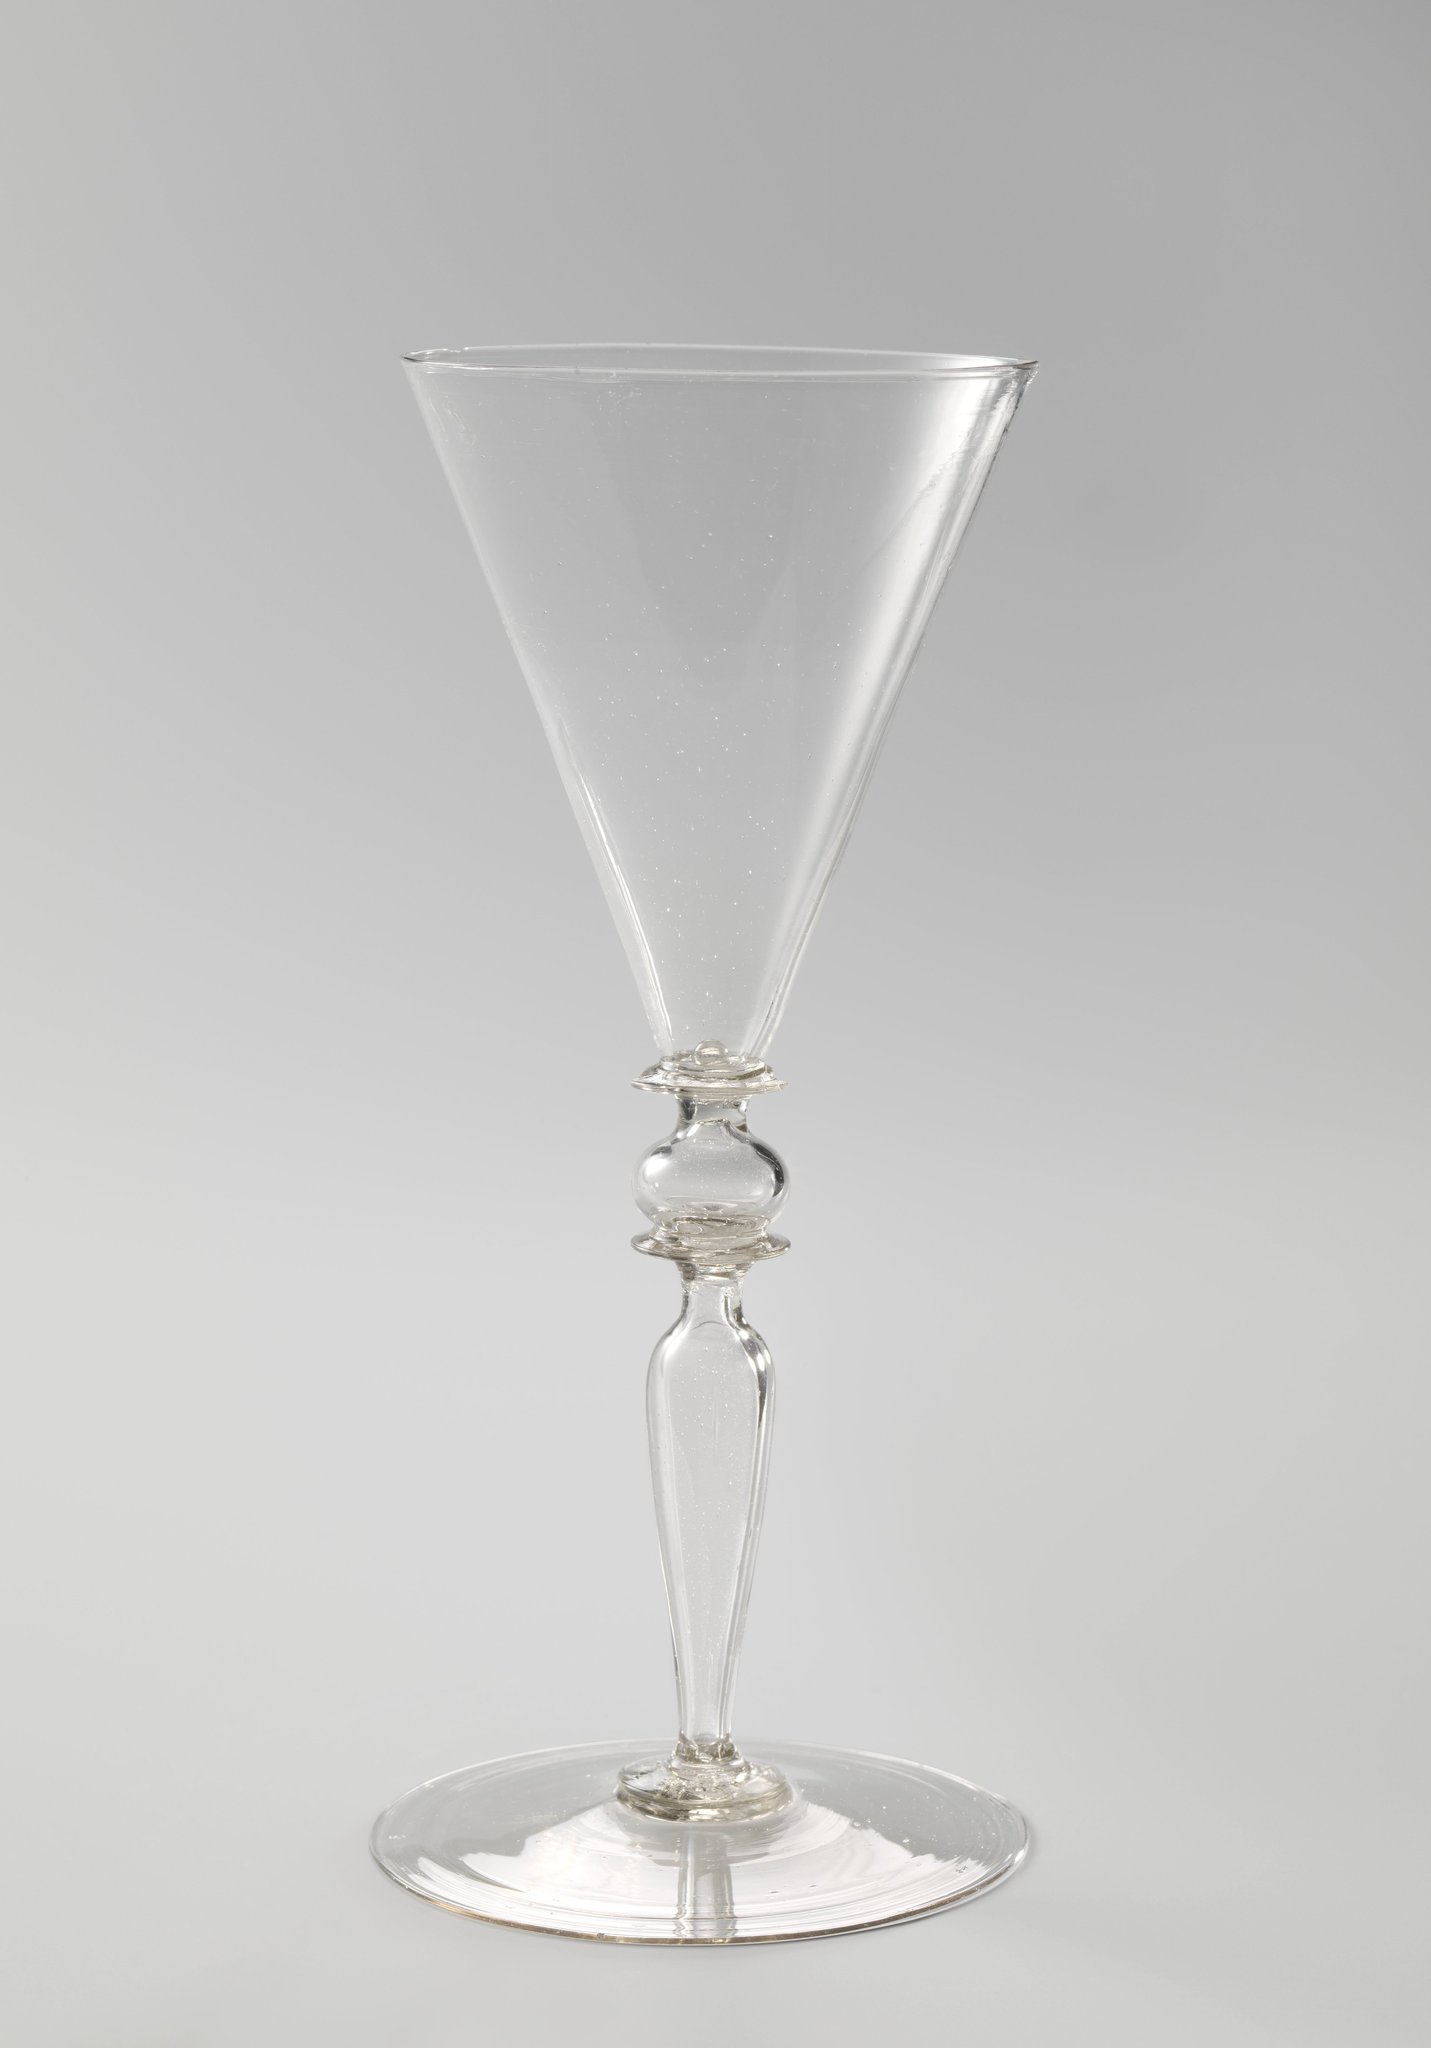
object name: goblet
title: Kelkglas met trechtervormige kelk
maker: Anonymous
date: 1575-1600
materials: glass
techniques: glassblowing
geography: venice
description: Platte voet, holle balustervormige stam met een nodus tussen twee schijven en een trechtervormige kelk.